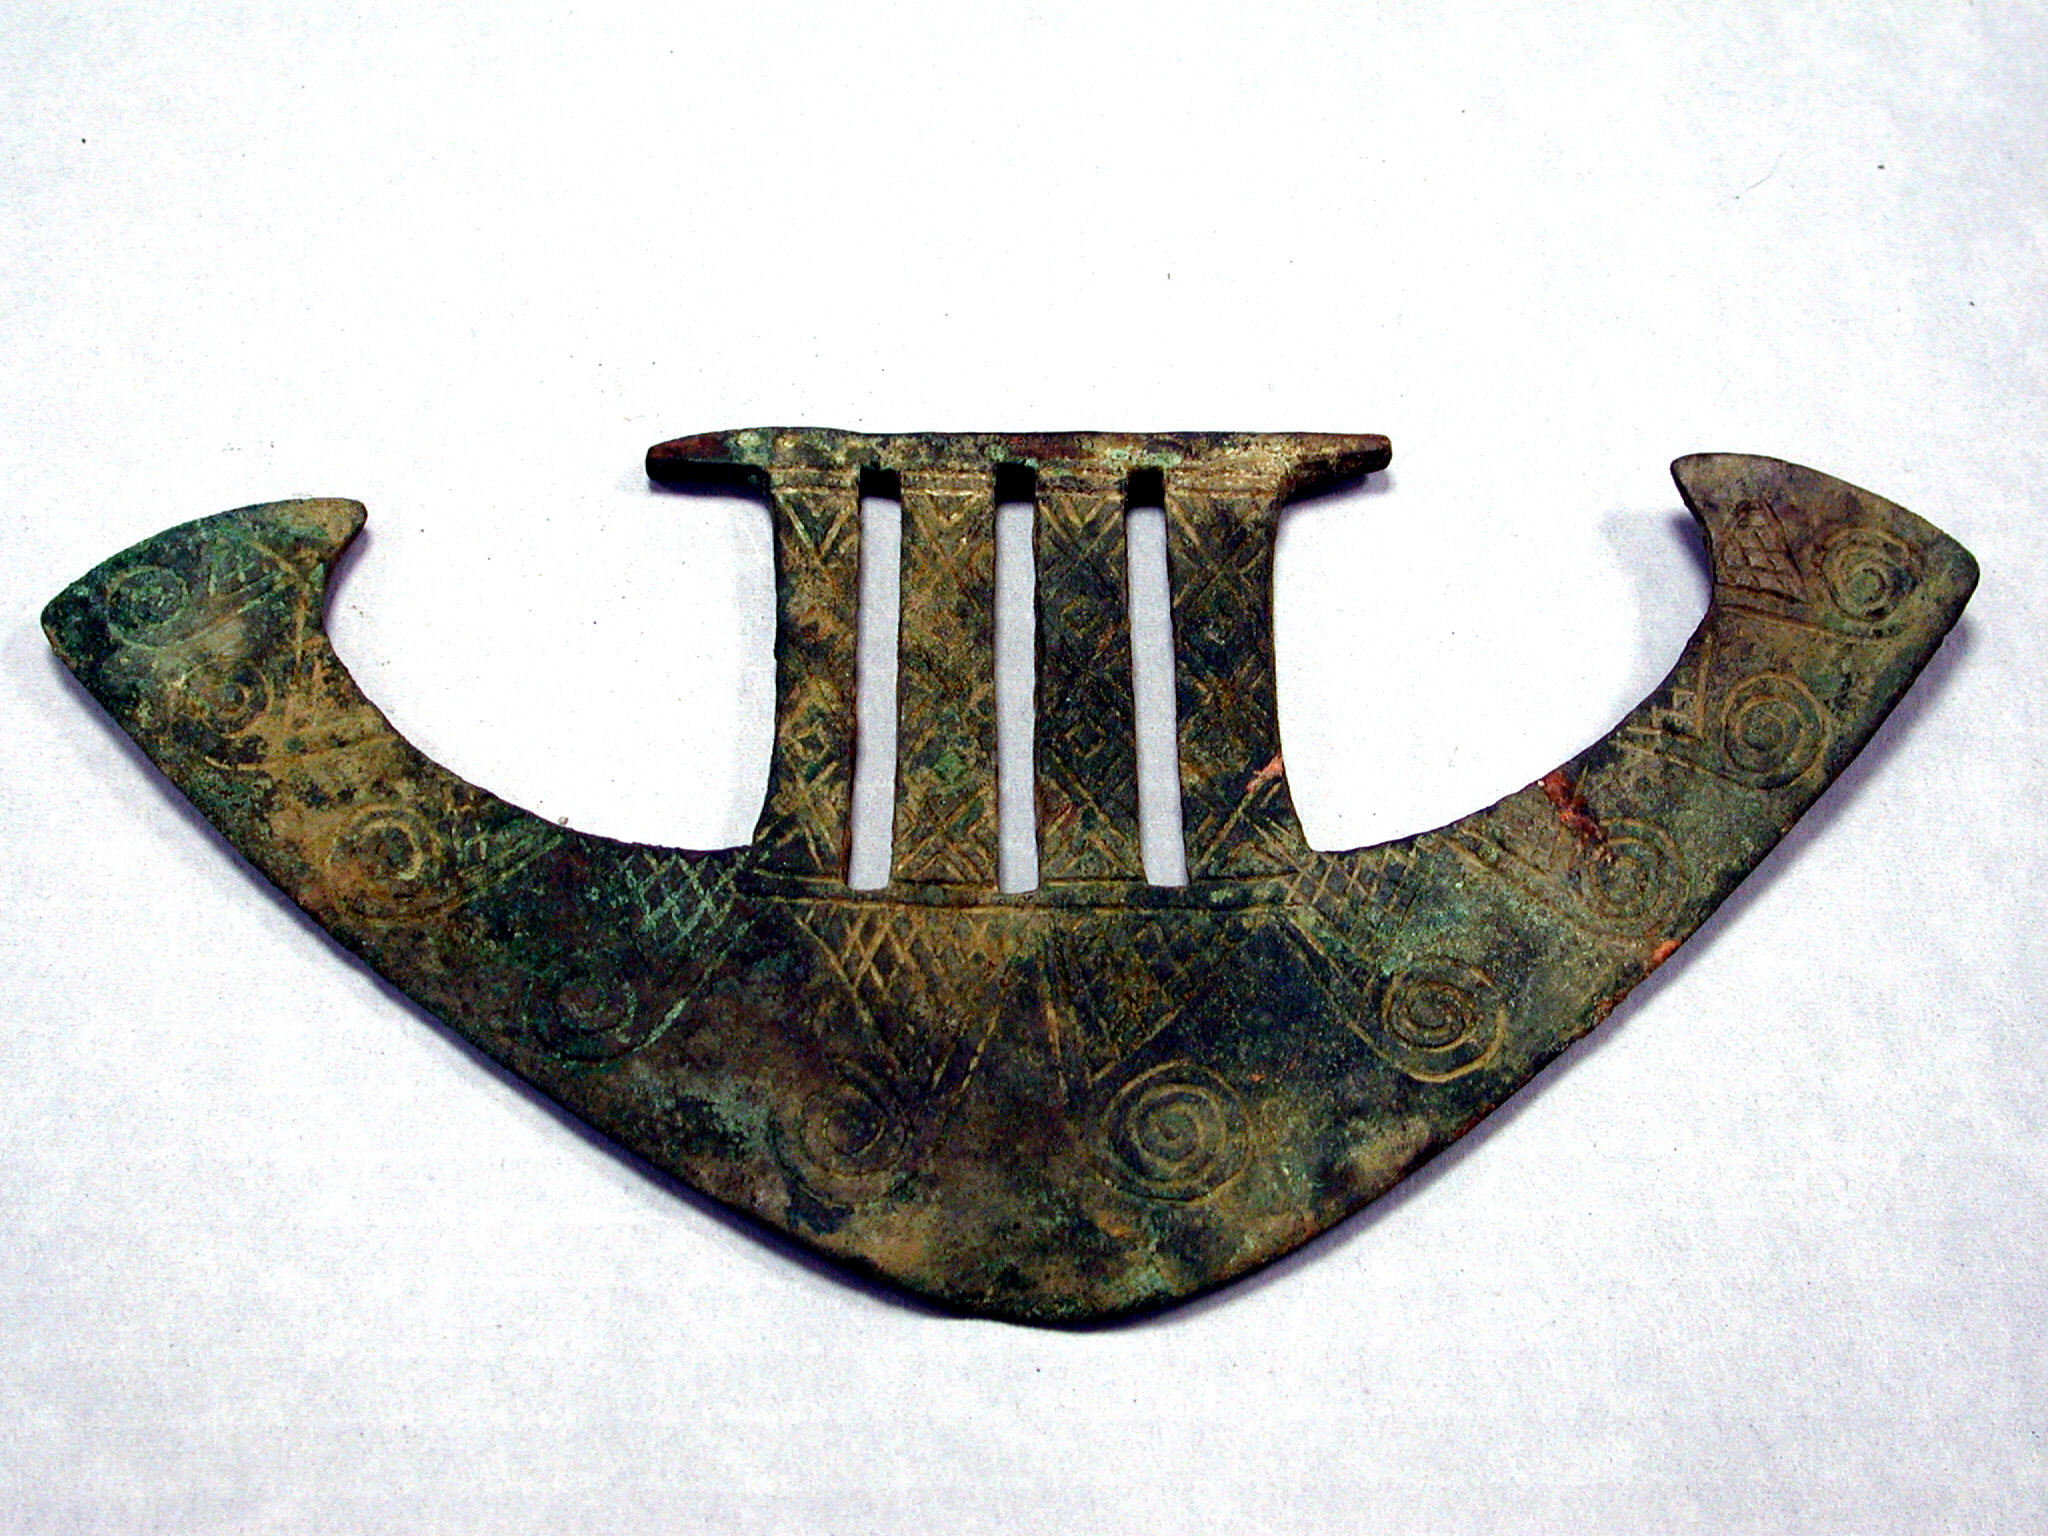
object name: ornament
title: Copper Axe Blade Ornament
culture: moche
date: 101-700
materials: copper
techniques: casting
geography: peru